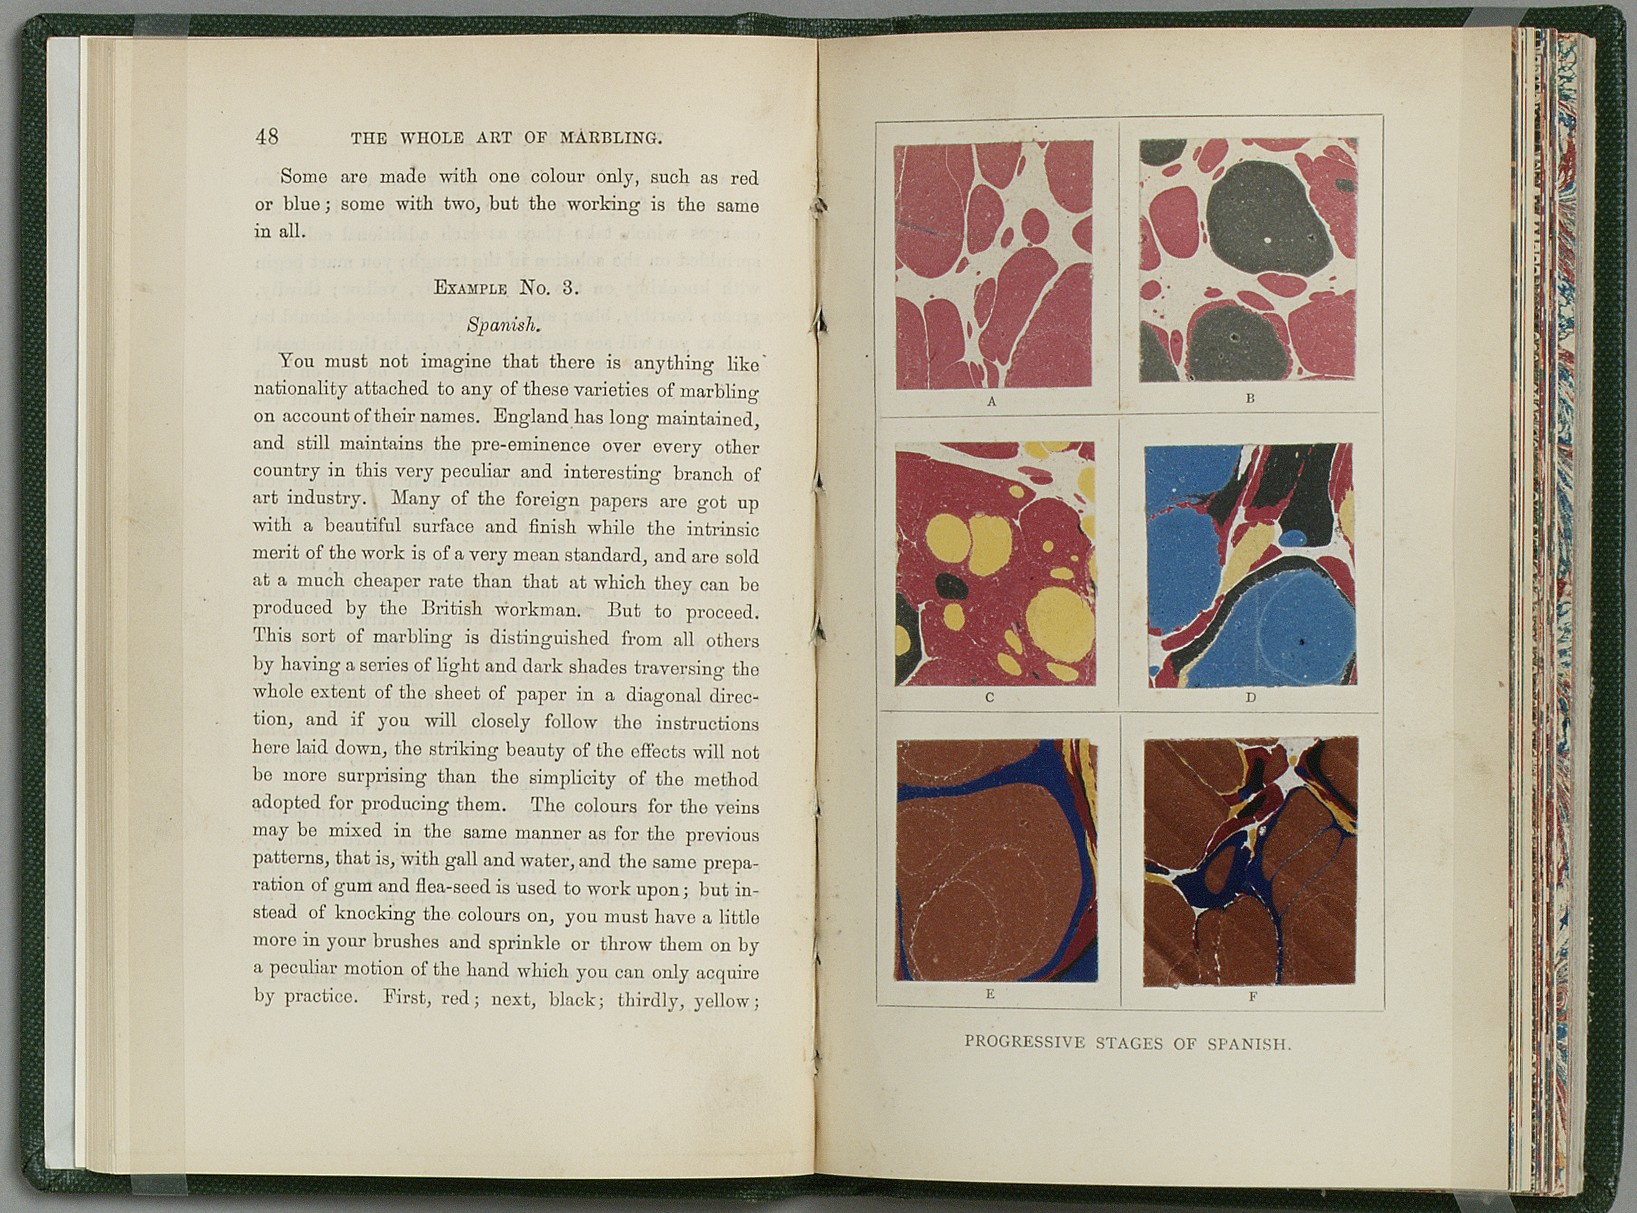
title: The Whole Art of Marbling as Applied to Paper, Book Edges, etc.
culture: british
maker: charles w. woolnough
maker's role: author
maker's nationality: british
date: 1881